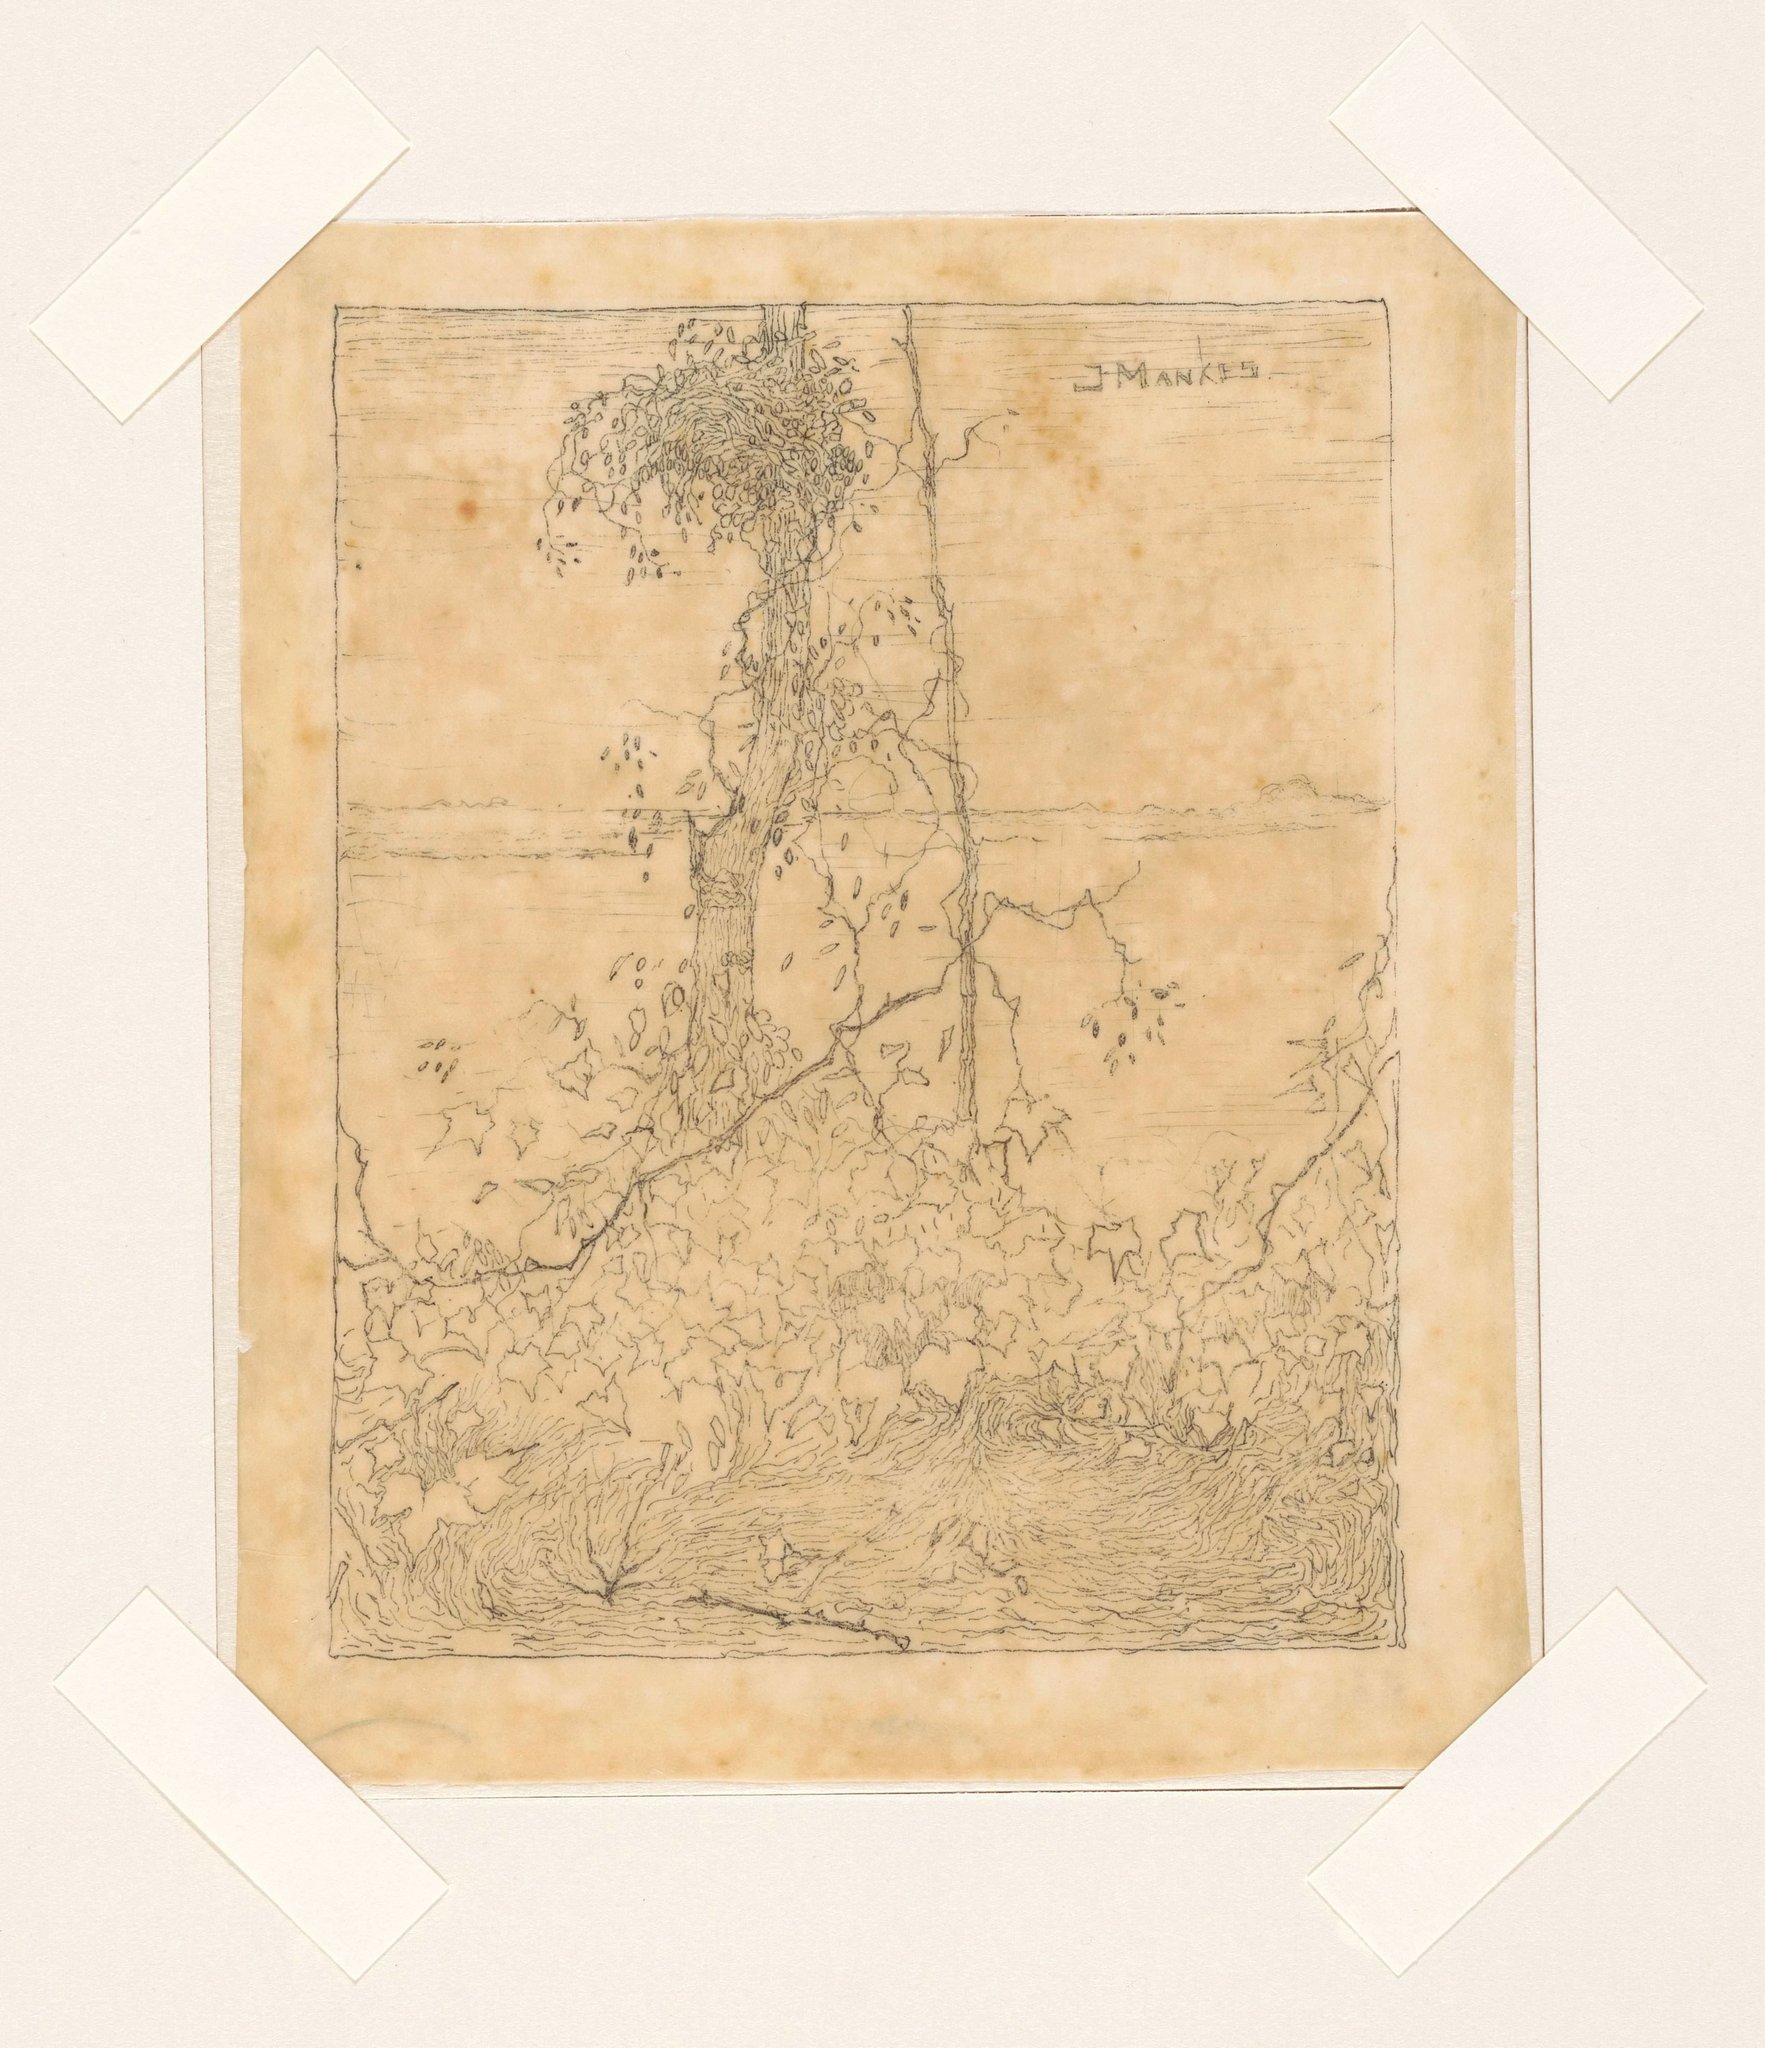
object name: drawing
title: Begroeide boomstam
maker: jan mankes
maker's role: draughtsman, painter, print maker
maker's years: 1889-1920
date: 1899-1920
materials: ink, parchment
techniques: pen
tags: trees